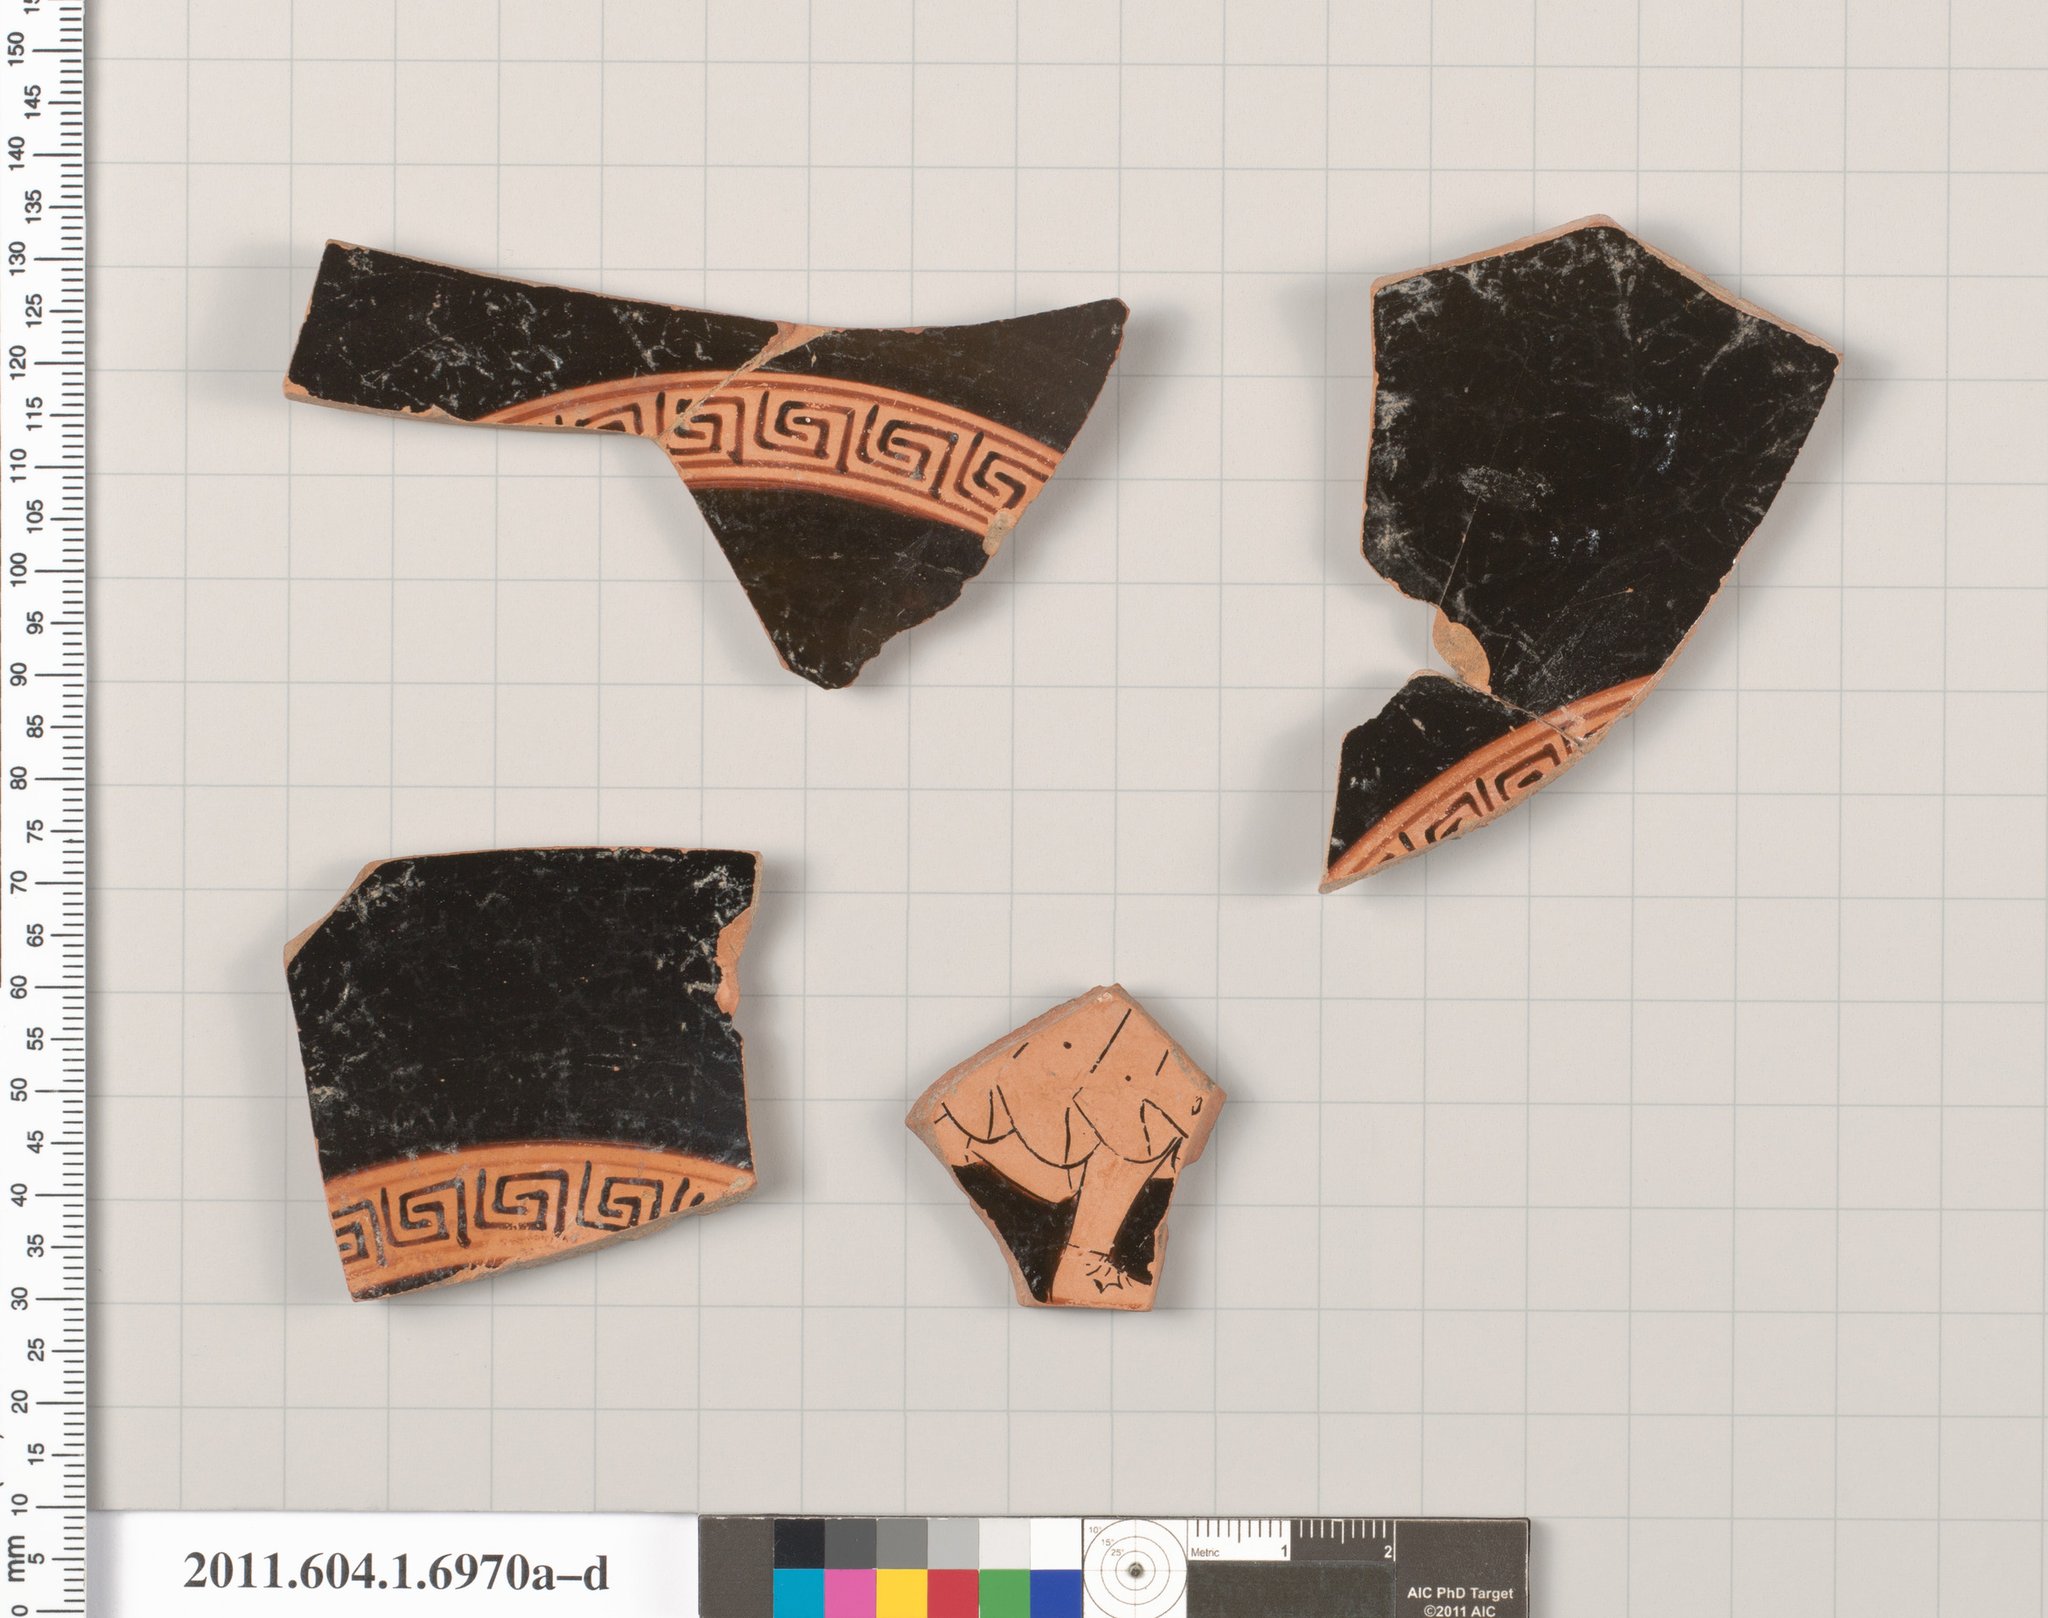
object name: kylix fragment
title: Terracotta fragments of a kylix (drinking cup)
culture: greek, attic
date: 490-470 BCE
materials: terracotta